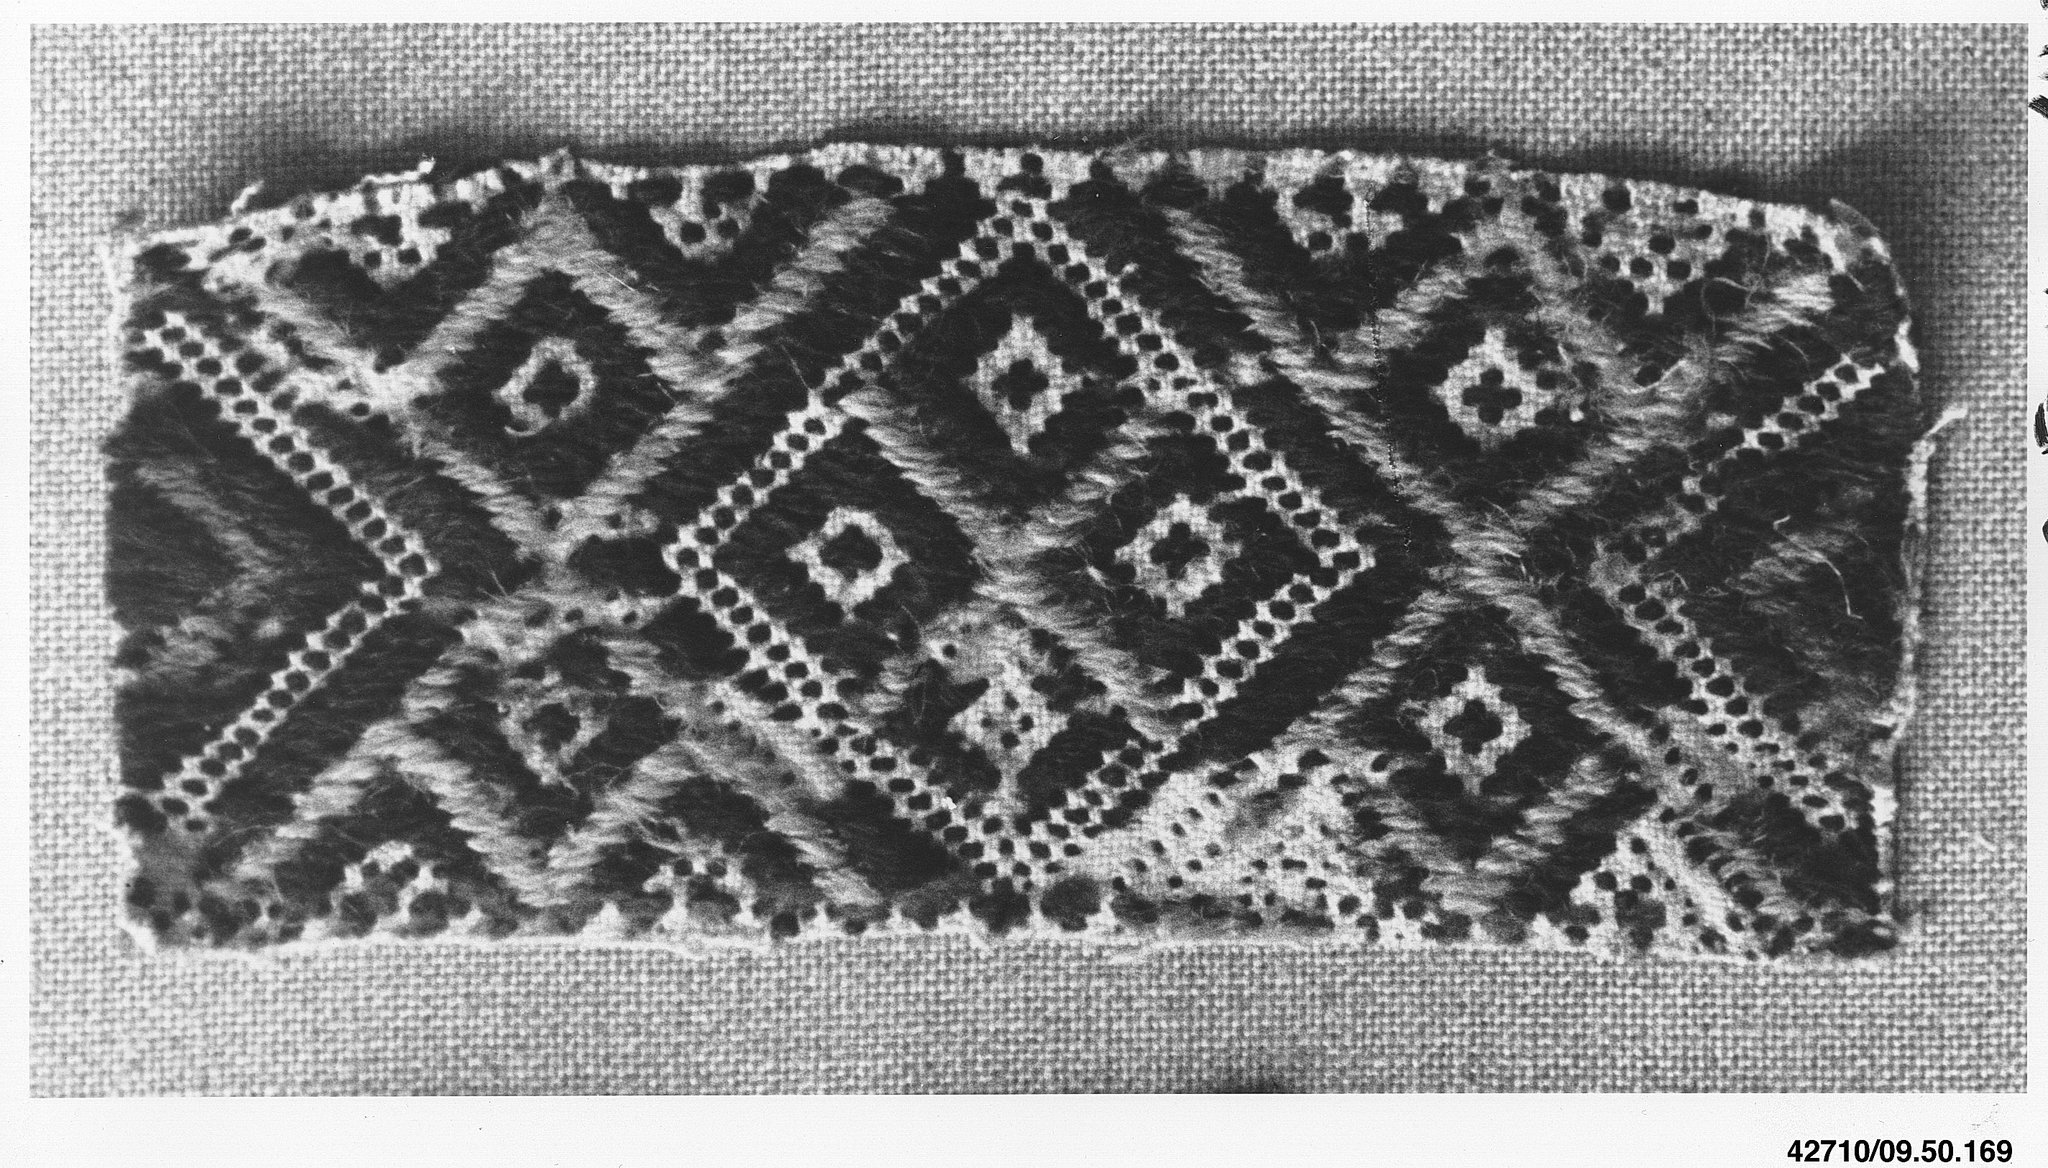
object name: costume fragment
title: Peasant costume fragment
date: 1701-1900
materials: canvas, wool